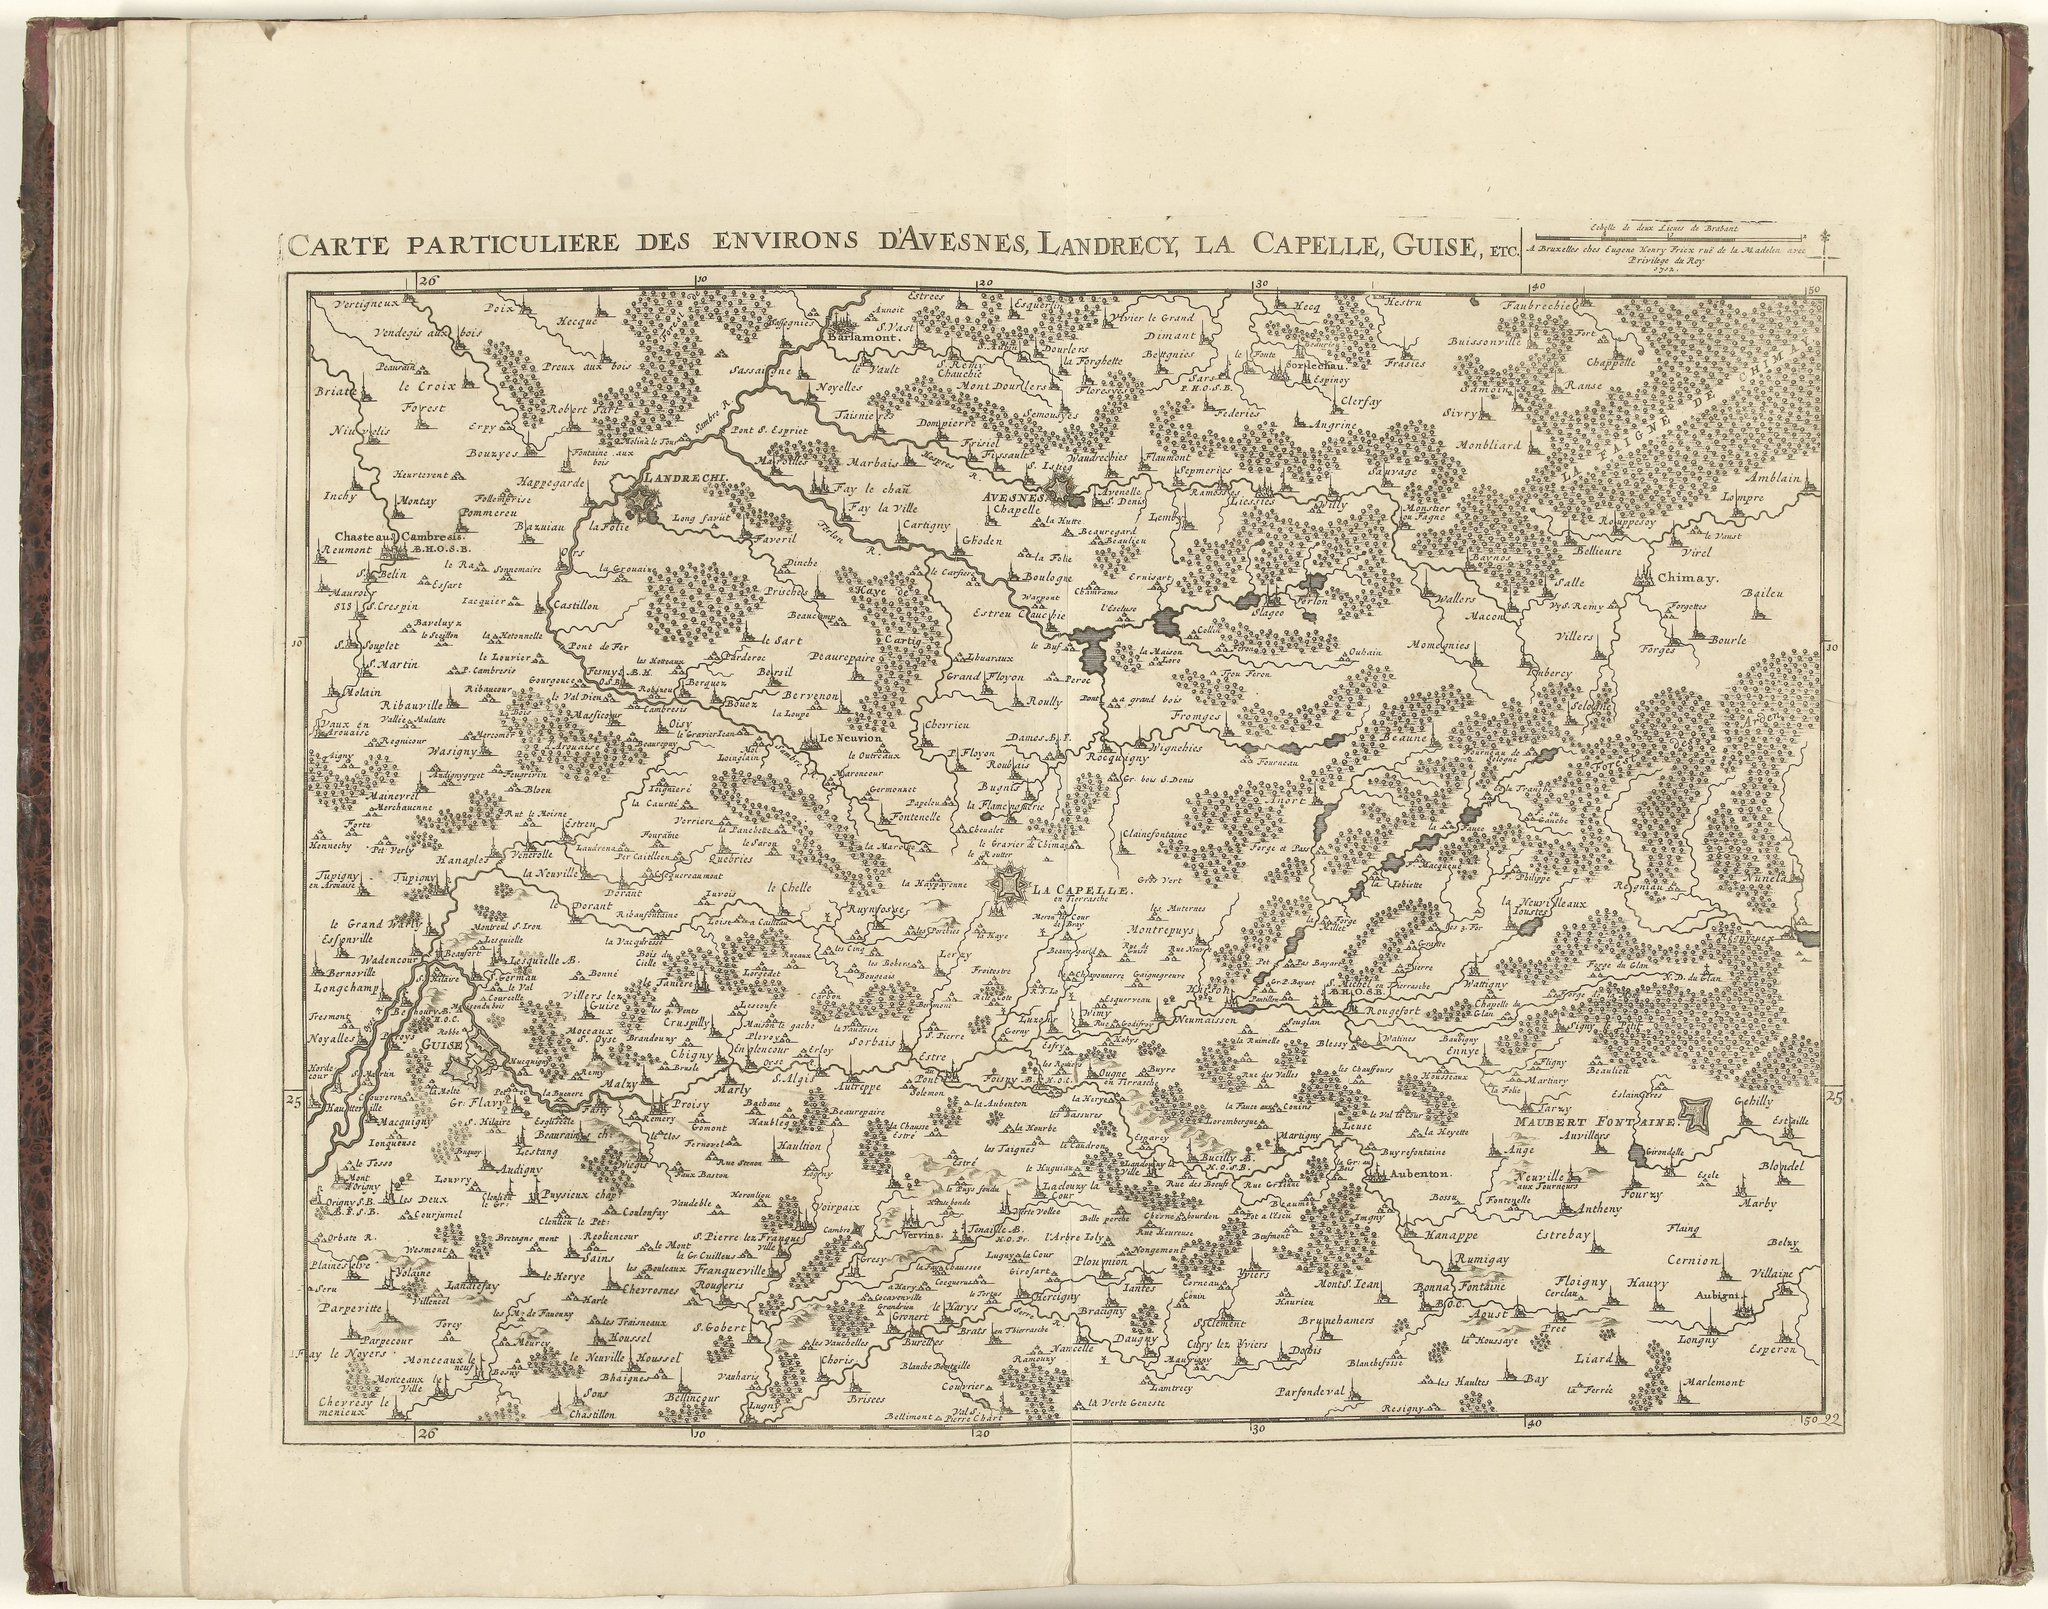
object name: print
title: Carte particuliere des environs d'Avesnes, Landrecy, la Capelle, Guise, etc.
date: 1712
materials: paper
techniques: engraving, etching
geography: brussels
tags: maps of separate countries or regions, northern france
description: Kaart van Noord-Frankrijk met de steden Avesnes, Landrecies, la Capelle en Guise, 1712. Onderdeel van een gebundelde verzameling van plannen van veldslagen en steden vermaard in de Spaanse Successieoorlog. Deze plaat behoort tot de eerste 24 platen die samen een zeer grote kaart van de Zuidelijke Nederlanden vormen.